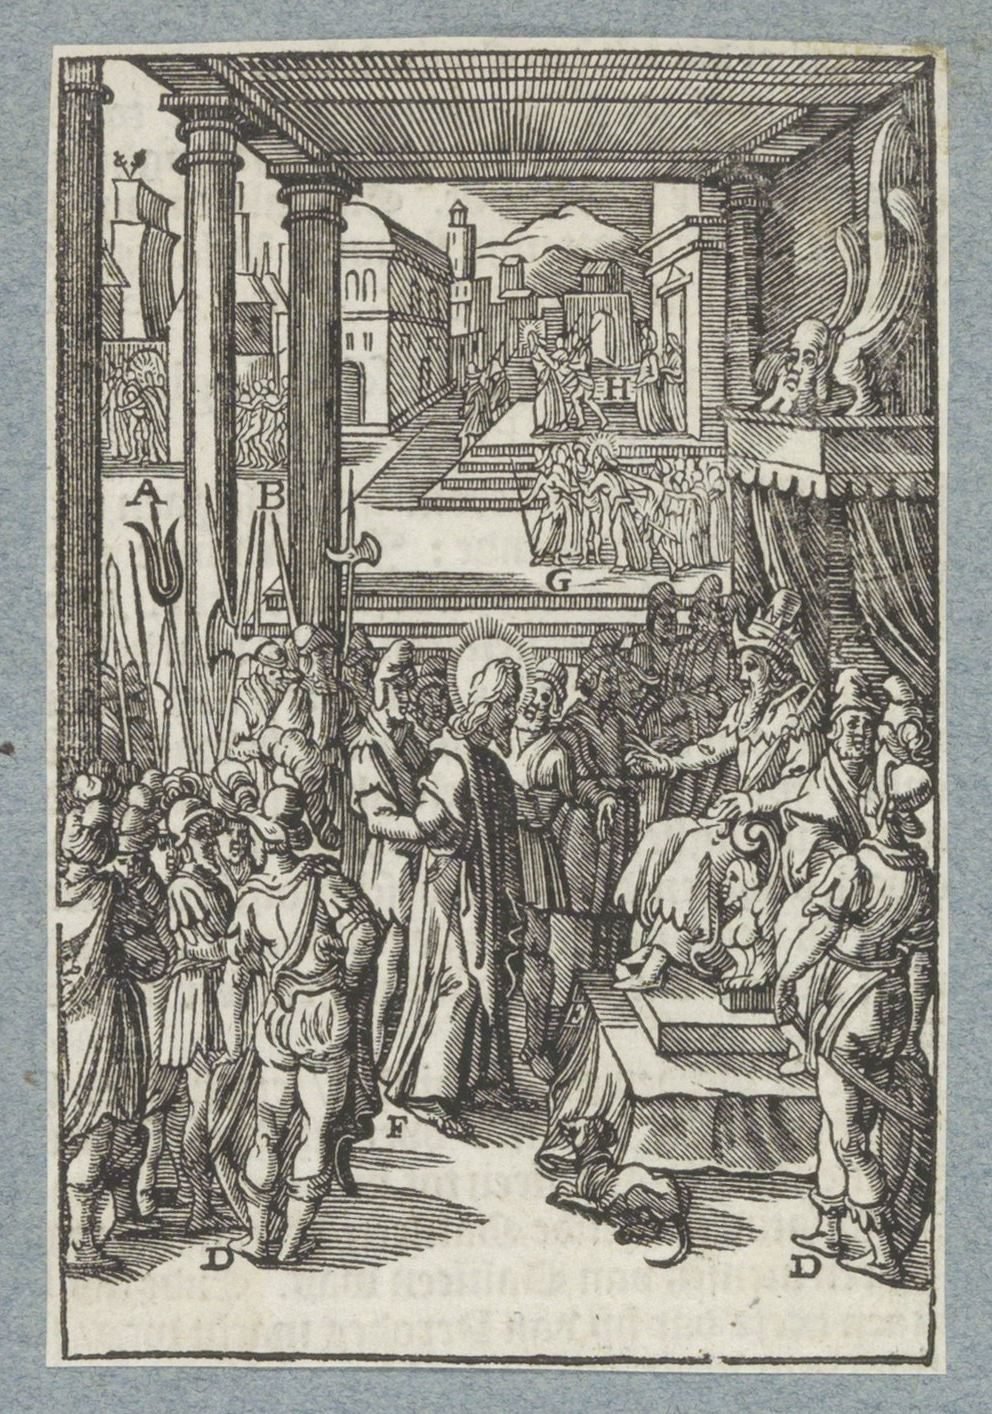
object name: book illustration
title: Christus voor Herodes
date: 1629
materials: paper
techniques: letterpress printing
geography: amsterdam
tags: christ before king herod; sometimes a gorgeous robe is brought (luke 23:8-11)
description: Christus wordt voorgeleid aan koning Herodes. Hij ondervraagt Christus, maar die antwoordt hem niet. Links op de achtergrond probeert een menigte een beeld te vangen van de gebeurtenissen. Rechts wordt Christus in een prachtig wit kleed terug naar Pilatus gestuurd. Bij verschillende elementen uit de voorstelling staan letters. De prent maakt deel uit van een album.